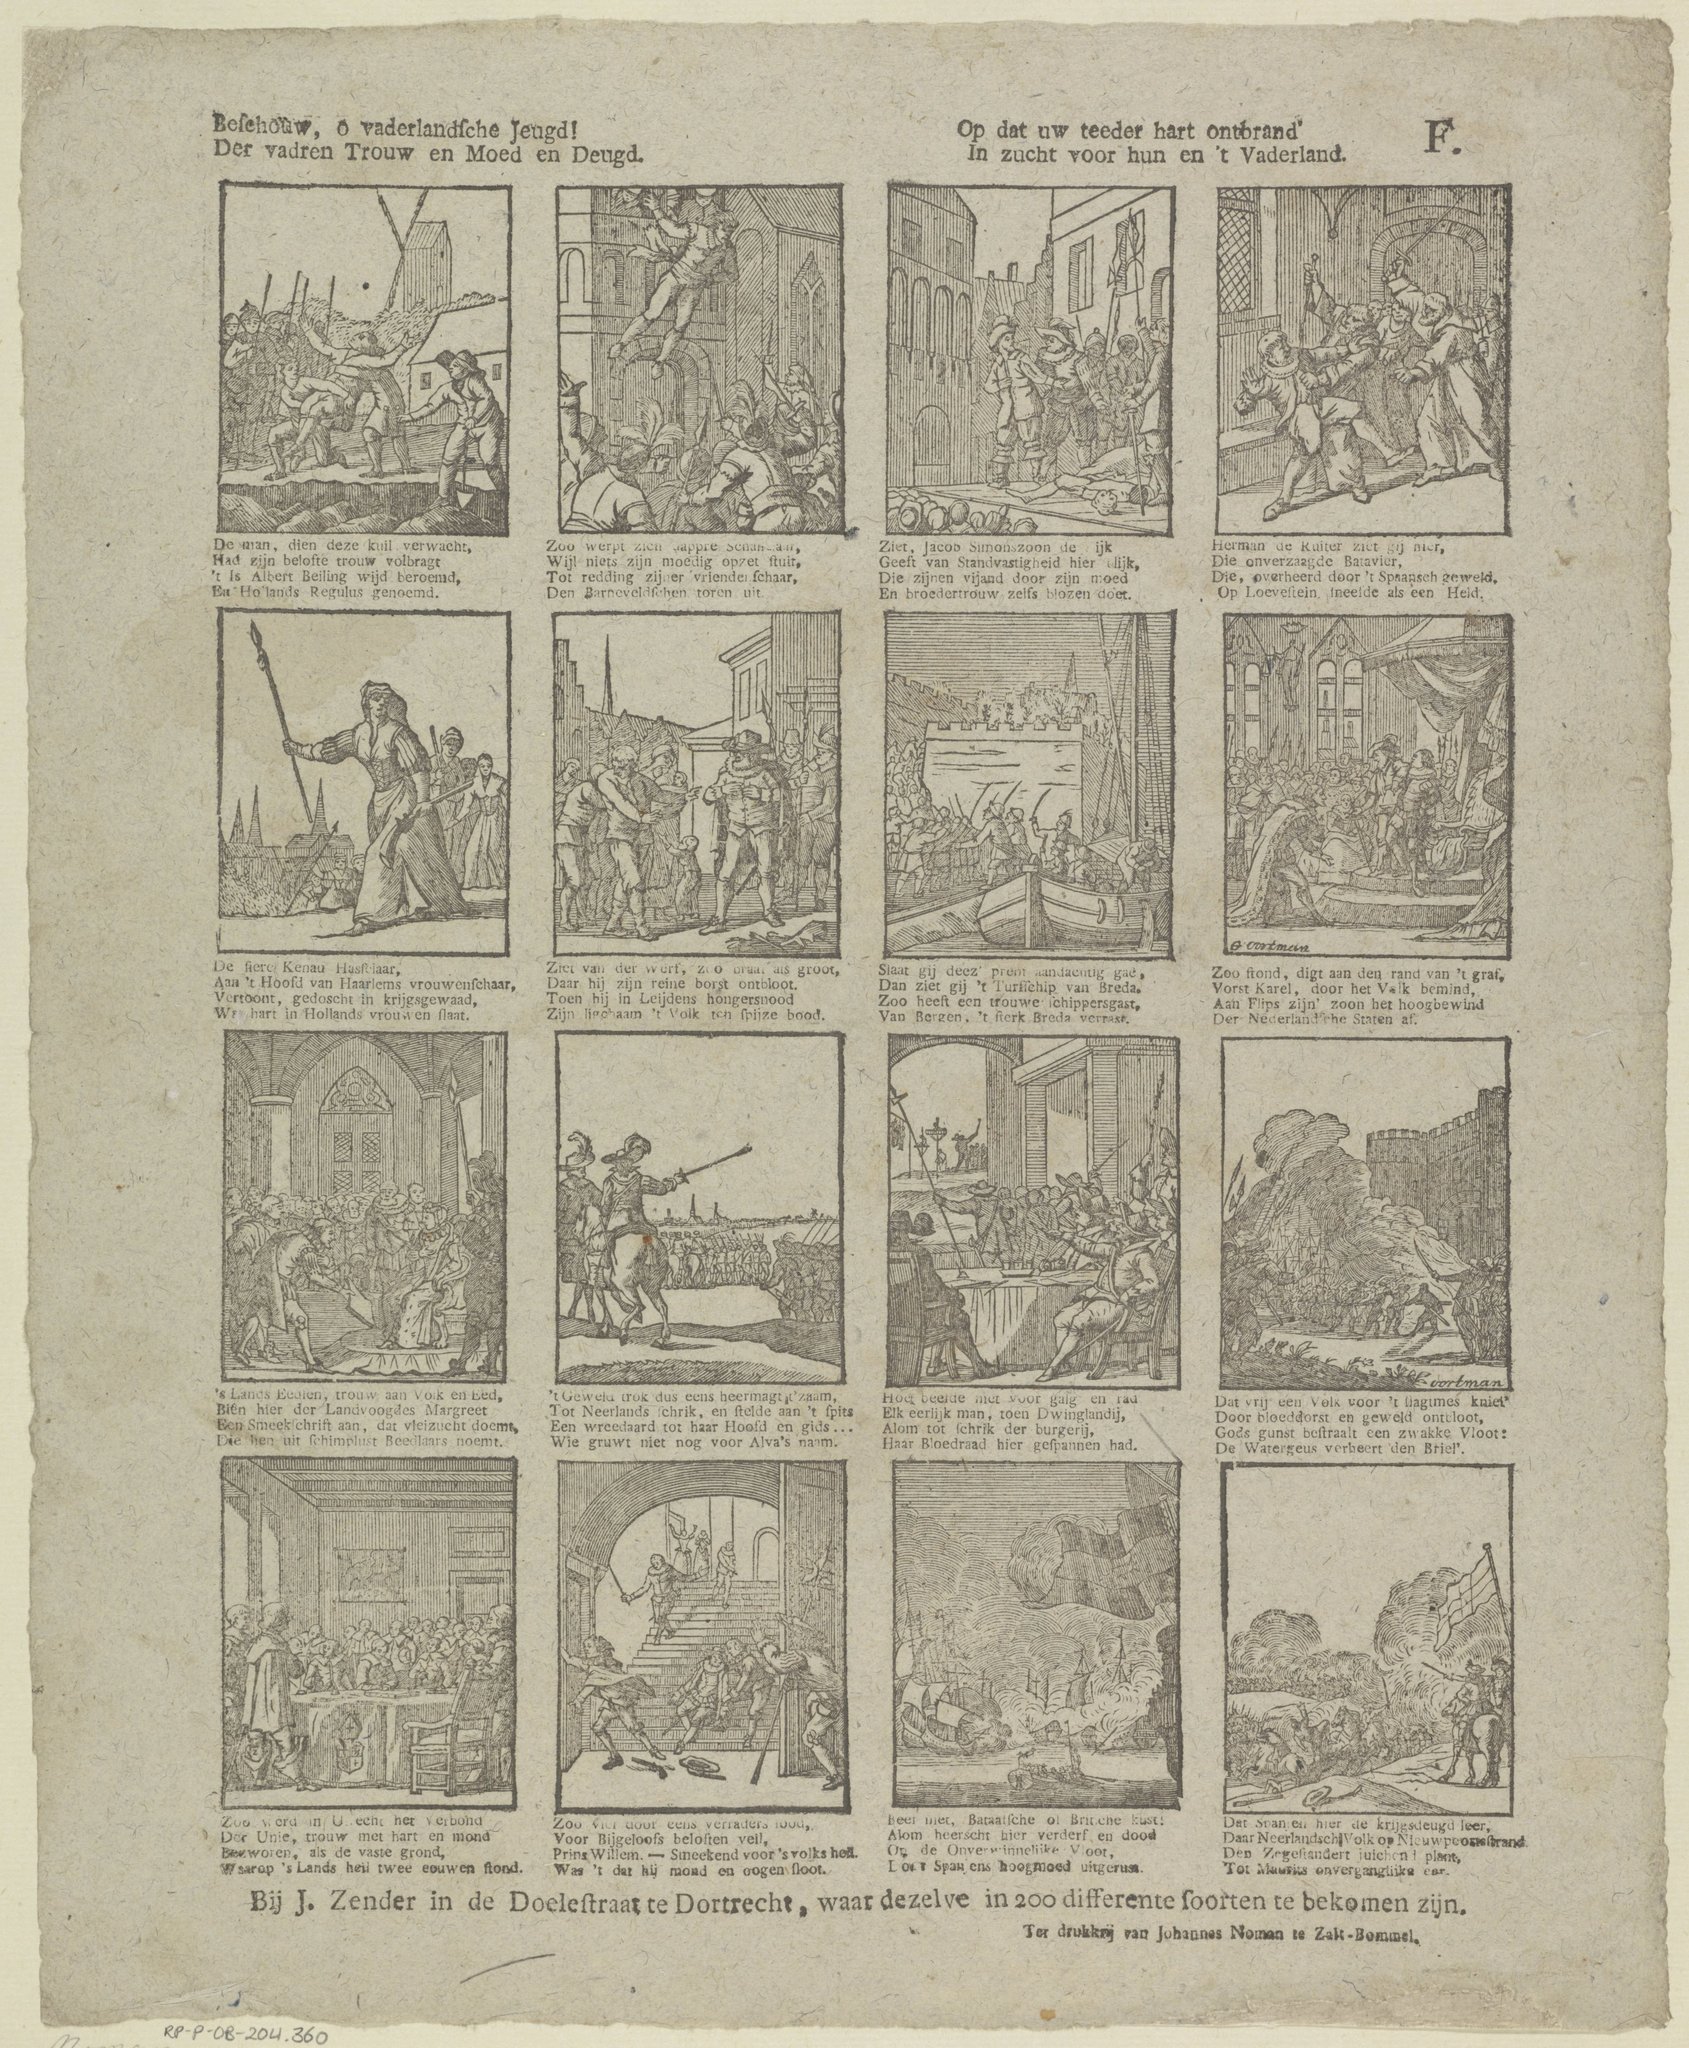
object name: print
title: Beschouw, o vaderlandsche jeugd! / Der vadren trouw en moed en deugd. / En dat uw teeder hart ontbrand'/ In zucht voor hun en 't vaderland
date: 1806-1847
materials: paper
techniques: letterpress printing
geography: zaltbommel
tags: philip ii of spain, delft, william i (prince of orange), the hague, maurice (prince of orange), fernando álvarez de toledo (3rd duke of alba), loevestein castle, ghent, charles v (holy roman emperor and king of spain), mayor, history, leiden, utrecht, battle of nieuwpoort, union of utrecht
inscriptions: collector's mark: Lugt 2760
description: Blad met 16 voorstellingen van gebeurtenissen uit de vaderlandse geschiedenis, zoals Jan van Schaffelaar die van de toren springt te Barneveld en de inname van Breda in 1590. Onder elke afbeelding een vierregelig vers. Gemerkt rechtsboven: F.